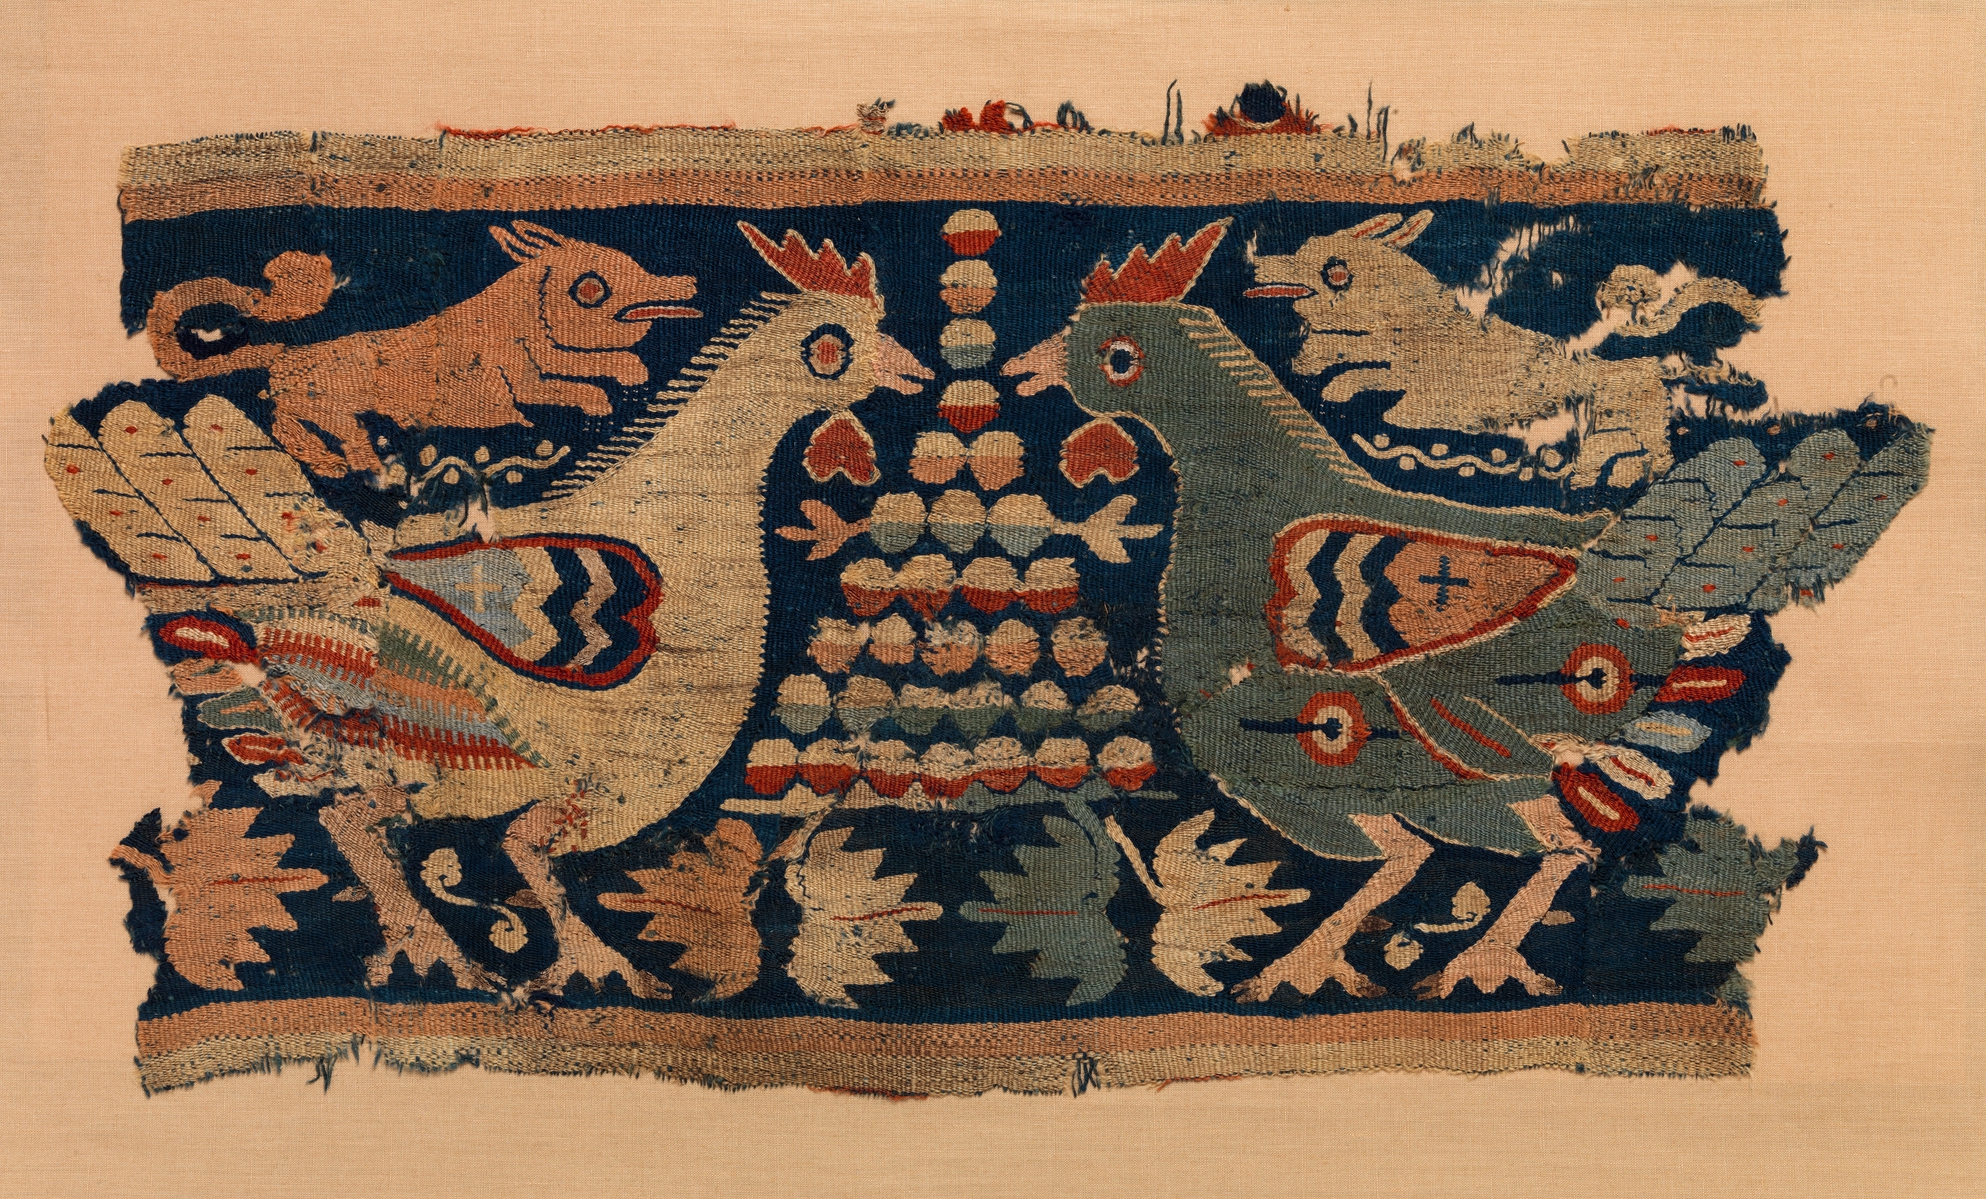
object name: textile fragment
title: Fragment of Wall Hanging with confronted cocks and running dogs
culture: coptic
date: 301-600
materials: linen, wool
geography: egypt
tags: roosters,dogs